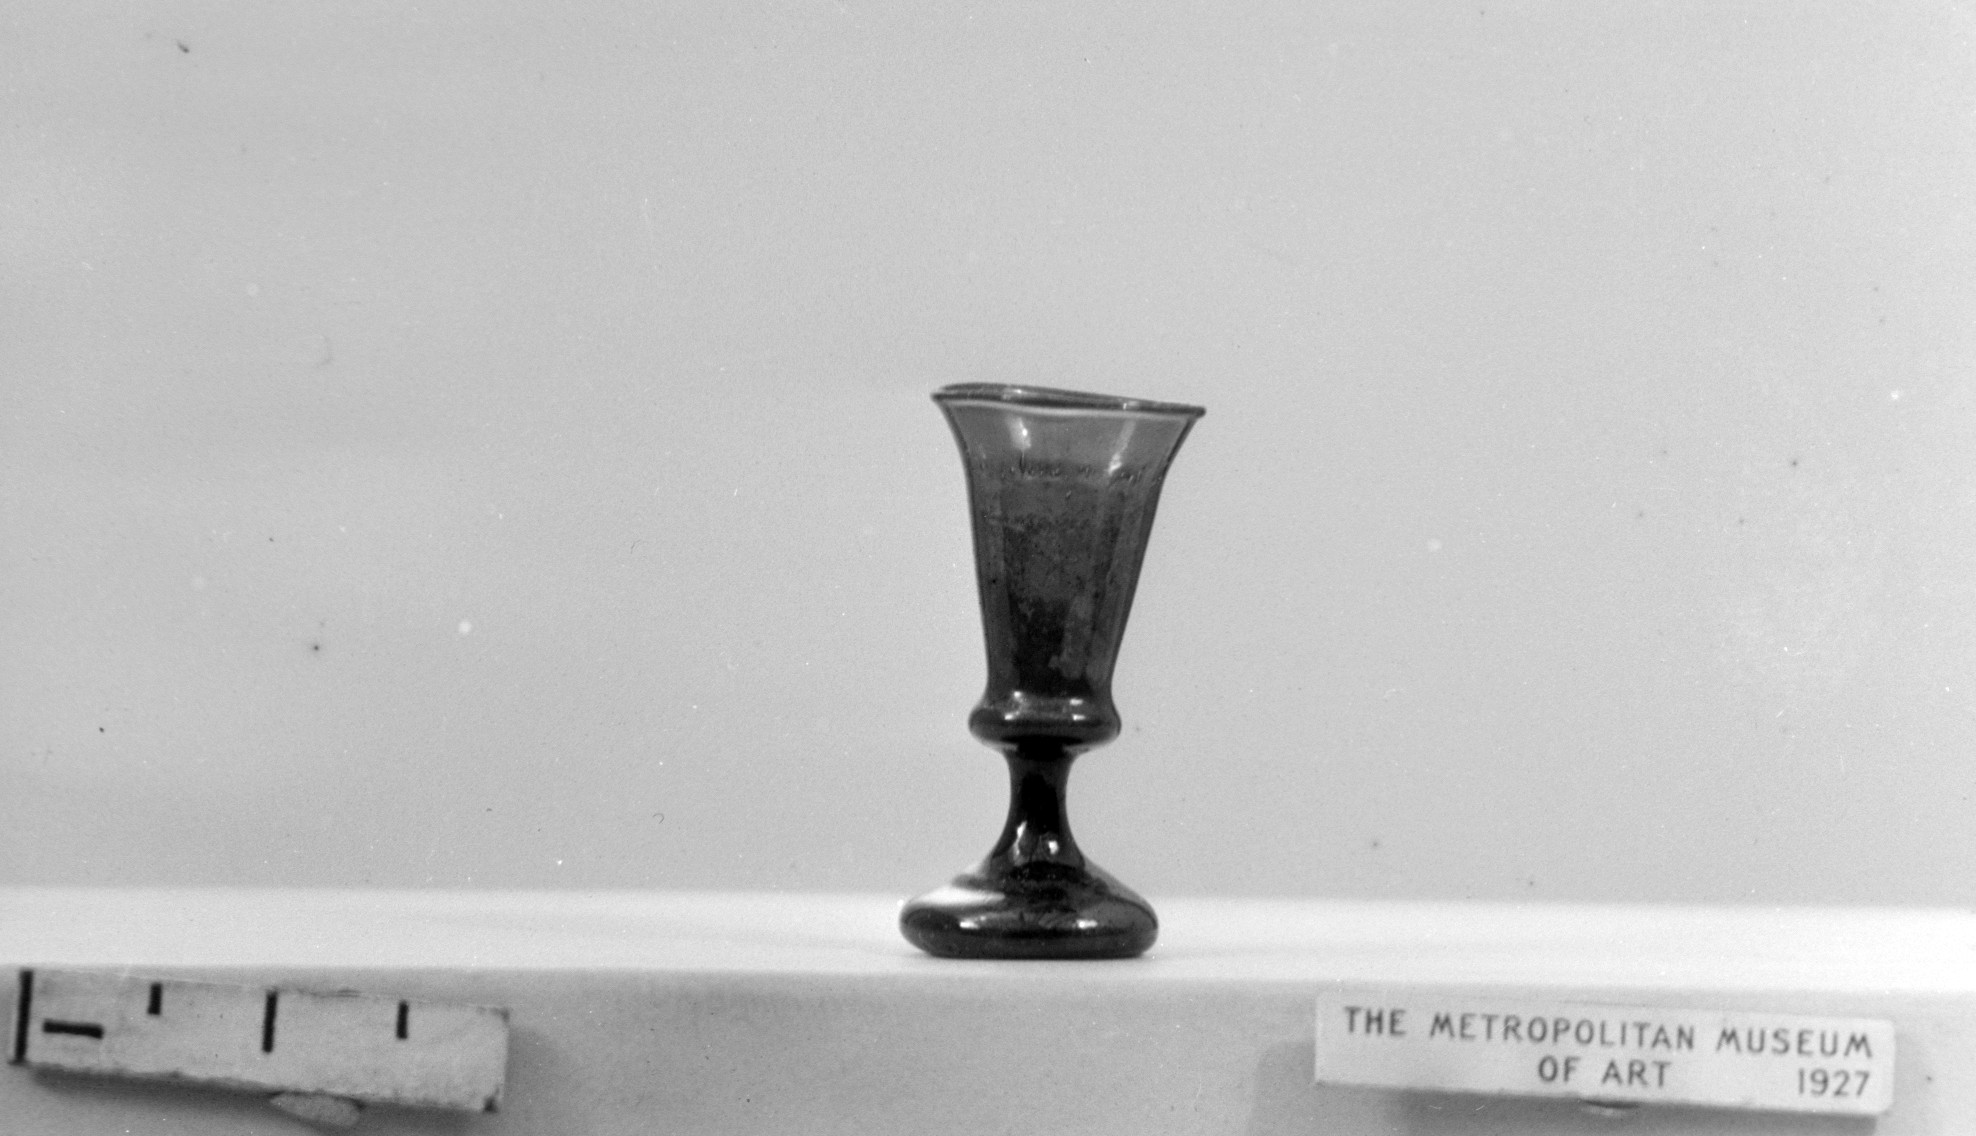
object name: goblet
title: Miniature goblet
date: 1801-1833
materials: glass